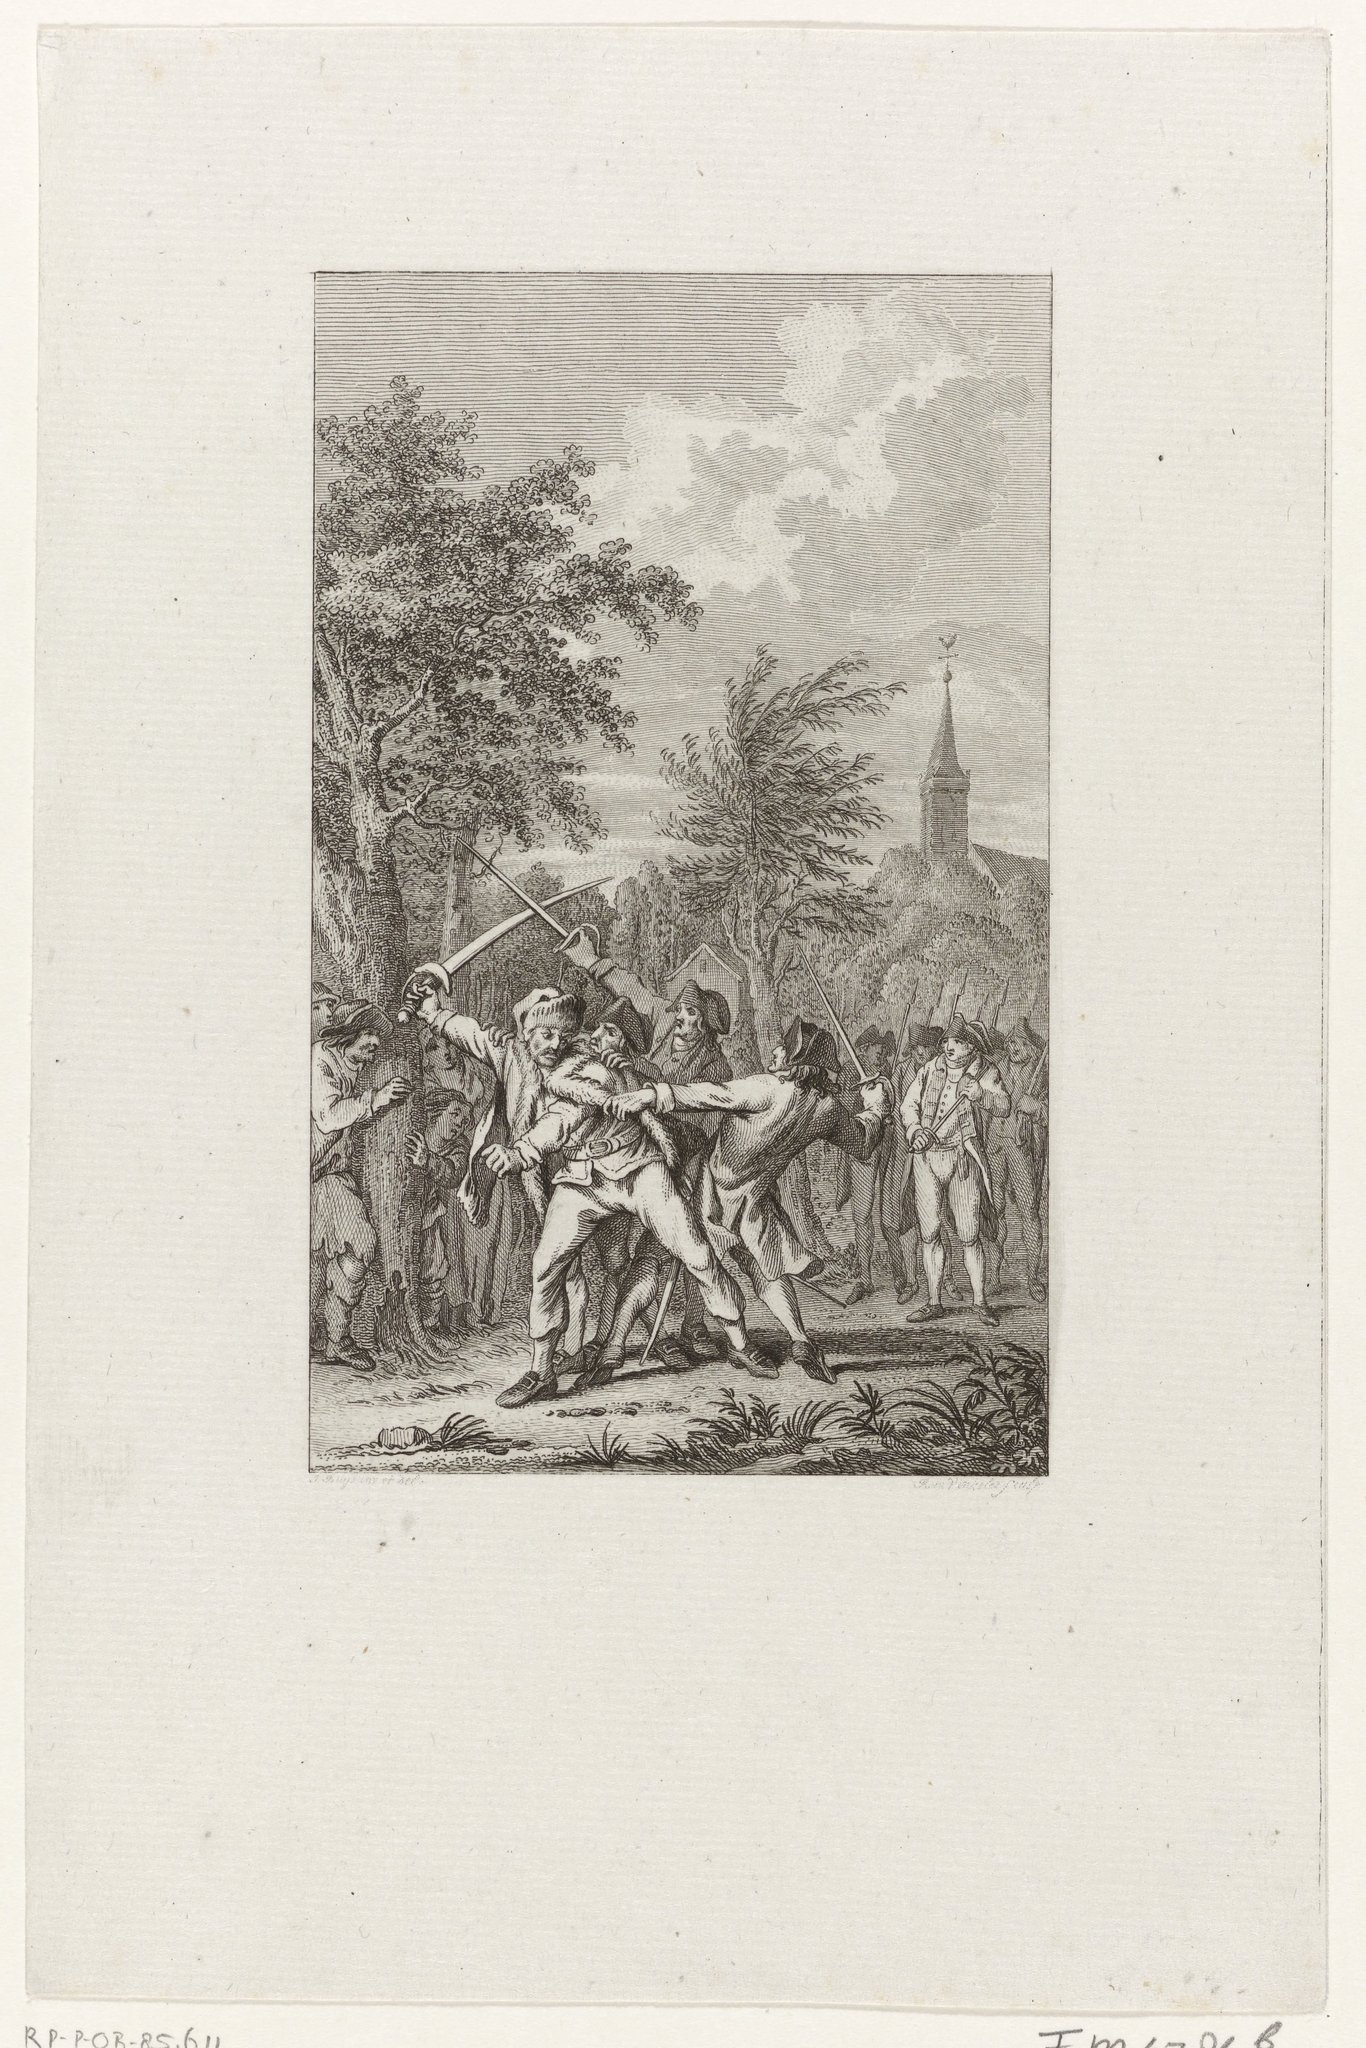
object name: print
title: Aanhouding van een oproerkraaier in de Ommelanden, 1787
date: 1797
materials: paper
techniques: engraving, etching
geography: northern netherlands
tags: arrest (of criminal), patriots (1780-1795)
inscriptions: collector's mark: Lugt 2228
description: Gebruikt als illustratie in: P.A. Loosjes, Vaderlandsche historie, vervattende de geschiedenissen, der Vereenigde Nederlanden (...). Ten onmiddelyken vervolge van Wagenaar's Vaderlandsche historie.